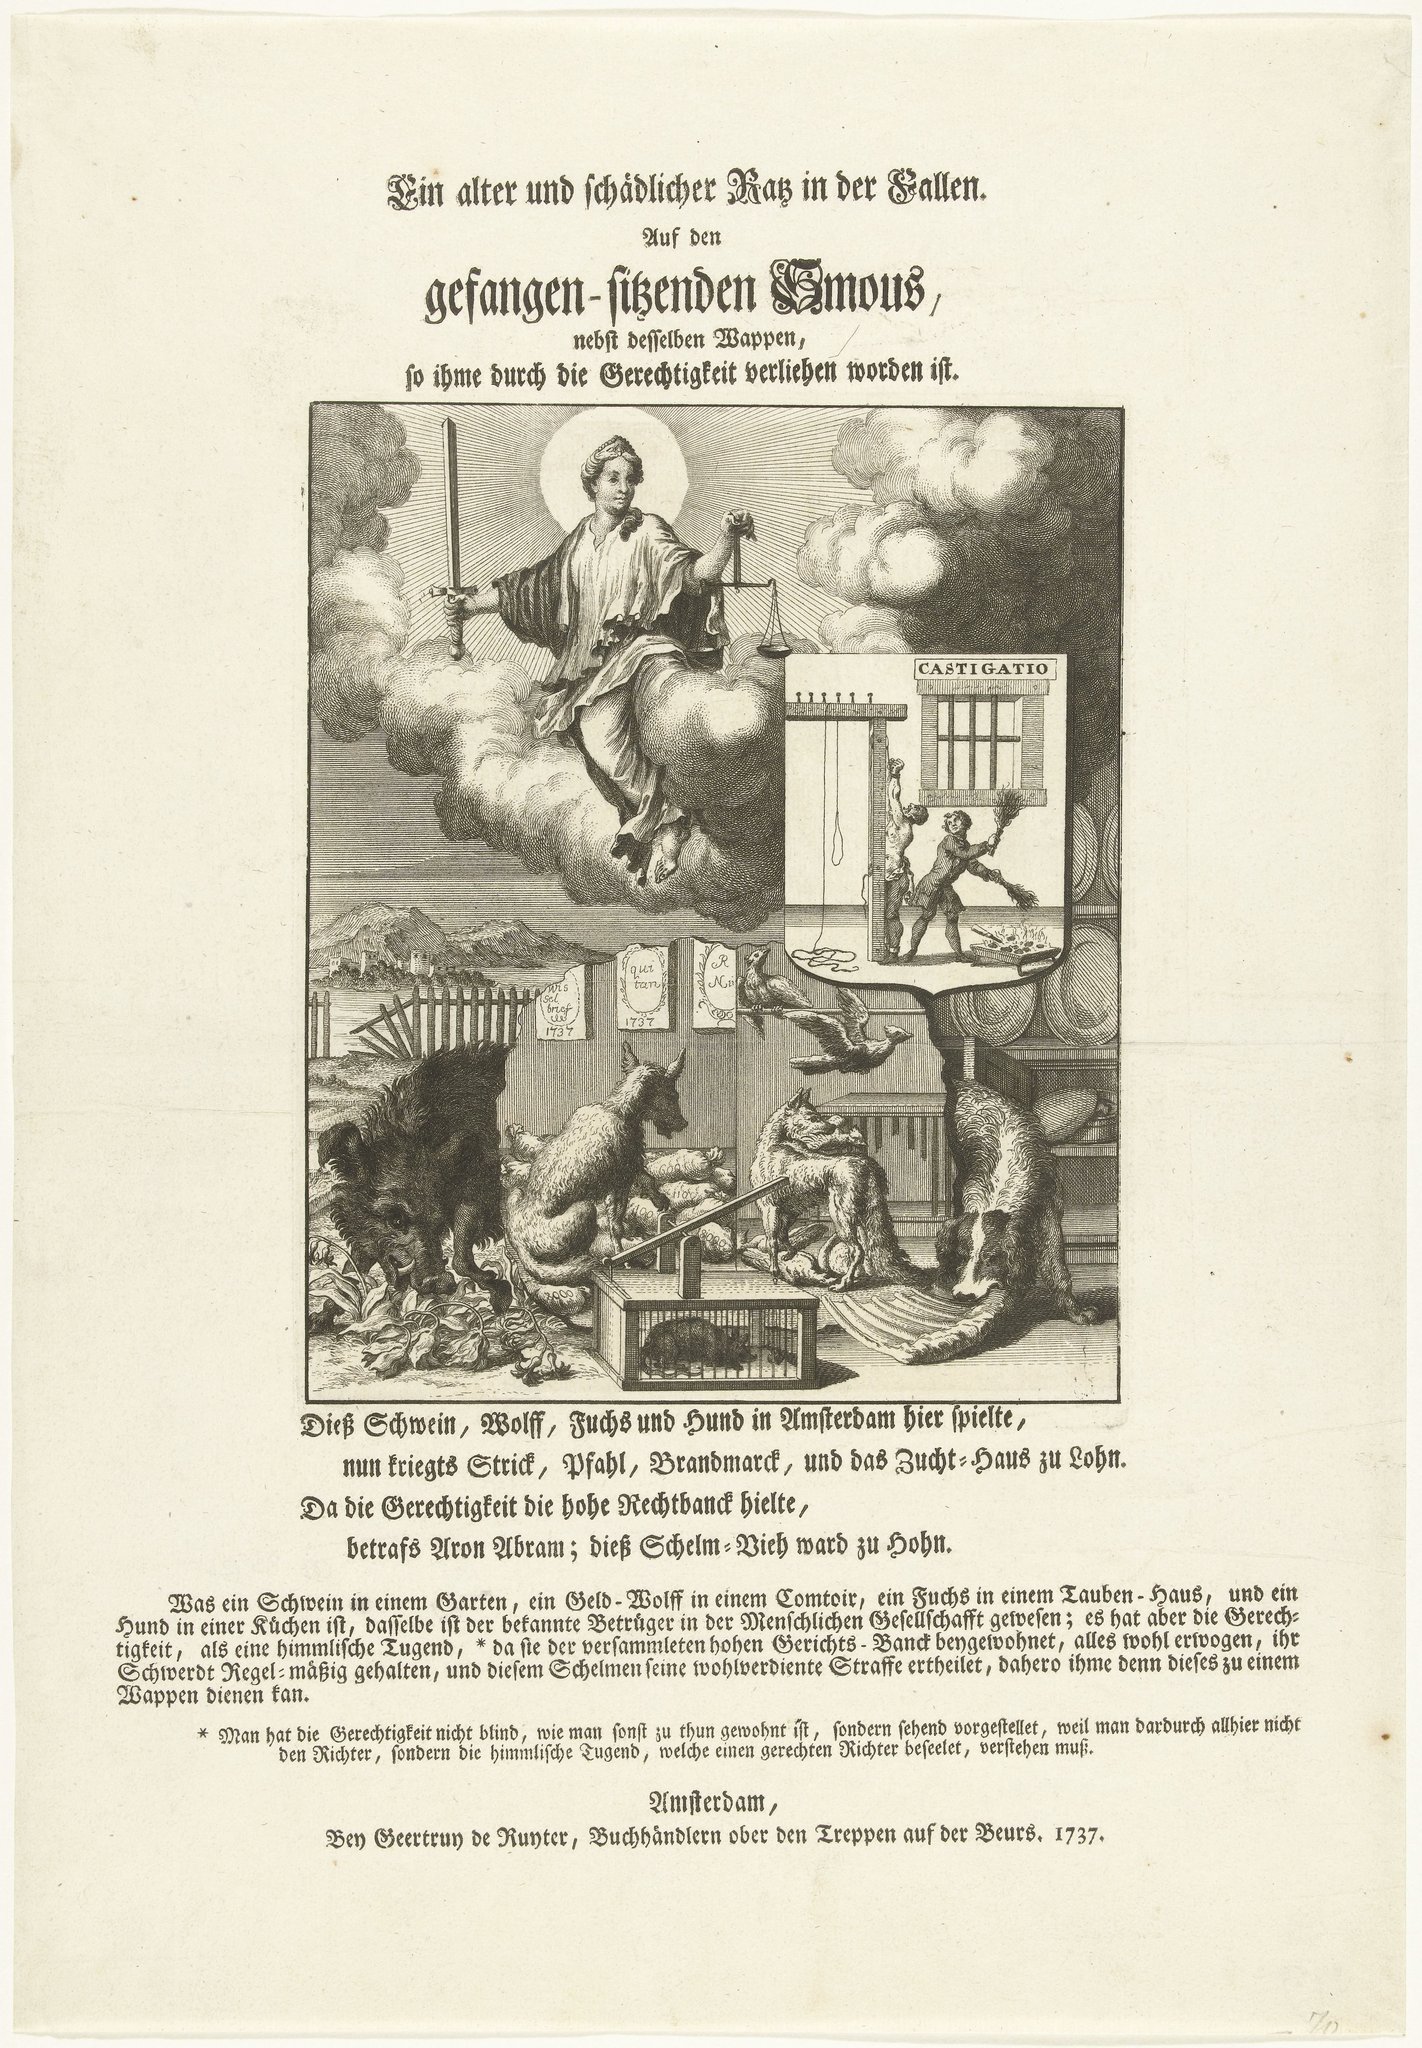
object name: print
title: Ein alter und schädlicher Ratz in der Fallen. Auf den gefangen-sitzenden Smous, nebst desselben Wappen, so ihme durch die Gerechtigkeit verliehen worden ist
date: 1737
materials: paper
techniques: etching, letterpress printing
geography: amsterdam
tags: amsterdam, anti-semitism, justice; 'forza alla giustitia sottoposta', 'giustitia', 'giustitia retta', 'giustitia rigorosa', 'impietà e violenza soggetta alla giustitia' (ripa), themis, dog with bone, instruments of torture, execution or punishment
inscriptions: collector's mark: Lugt 2228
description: De Amsterdamse joodse bedrieger Aron Abrams of Abrahams wordt gegeseld en gebrandmerkt. In de wolken Justitia met zwaard en weegschaal maar zonder blinddoek. Onder vier dieren die symbool staan voor 'de slechte Jood': een wroetend zwijn, een wolf in een bankkluis, een vos in een duiventil en een hond in de keuken. De rat in de val staat voor Abrahams zelf die nu gevangen zit. Onder de voorstelling een vers en tekst met uitleg over de prent in het Duits.